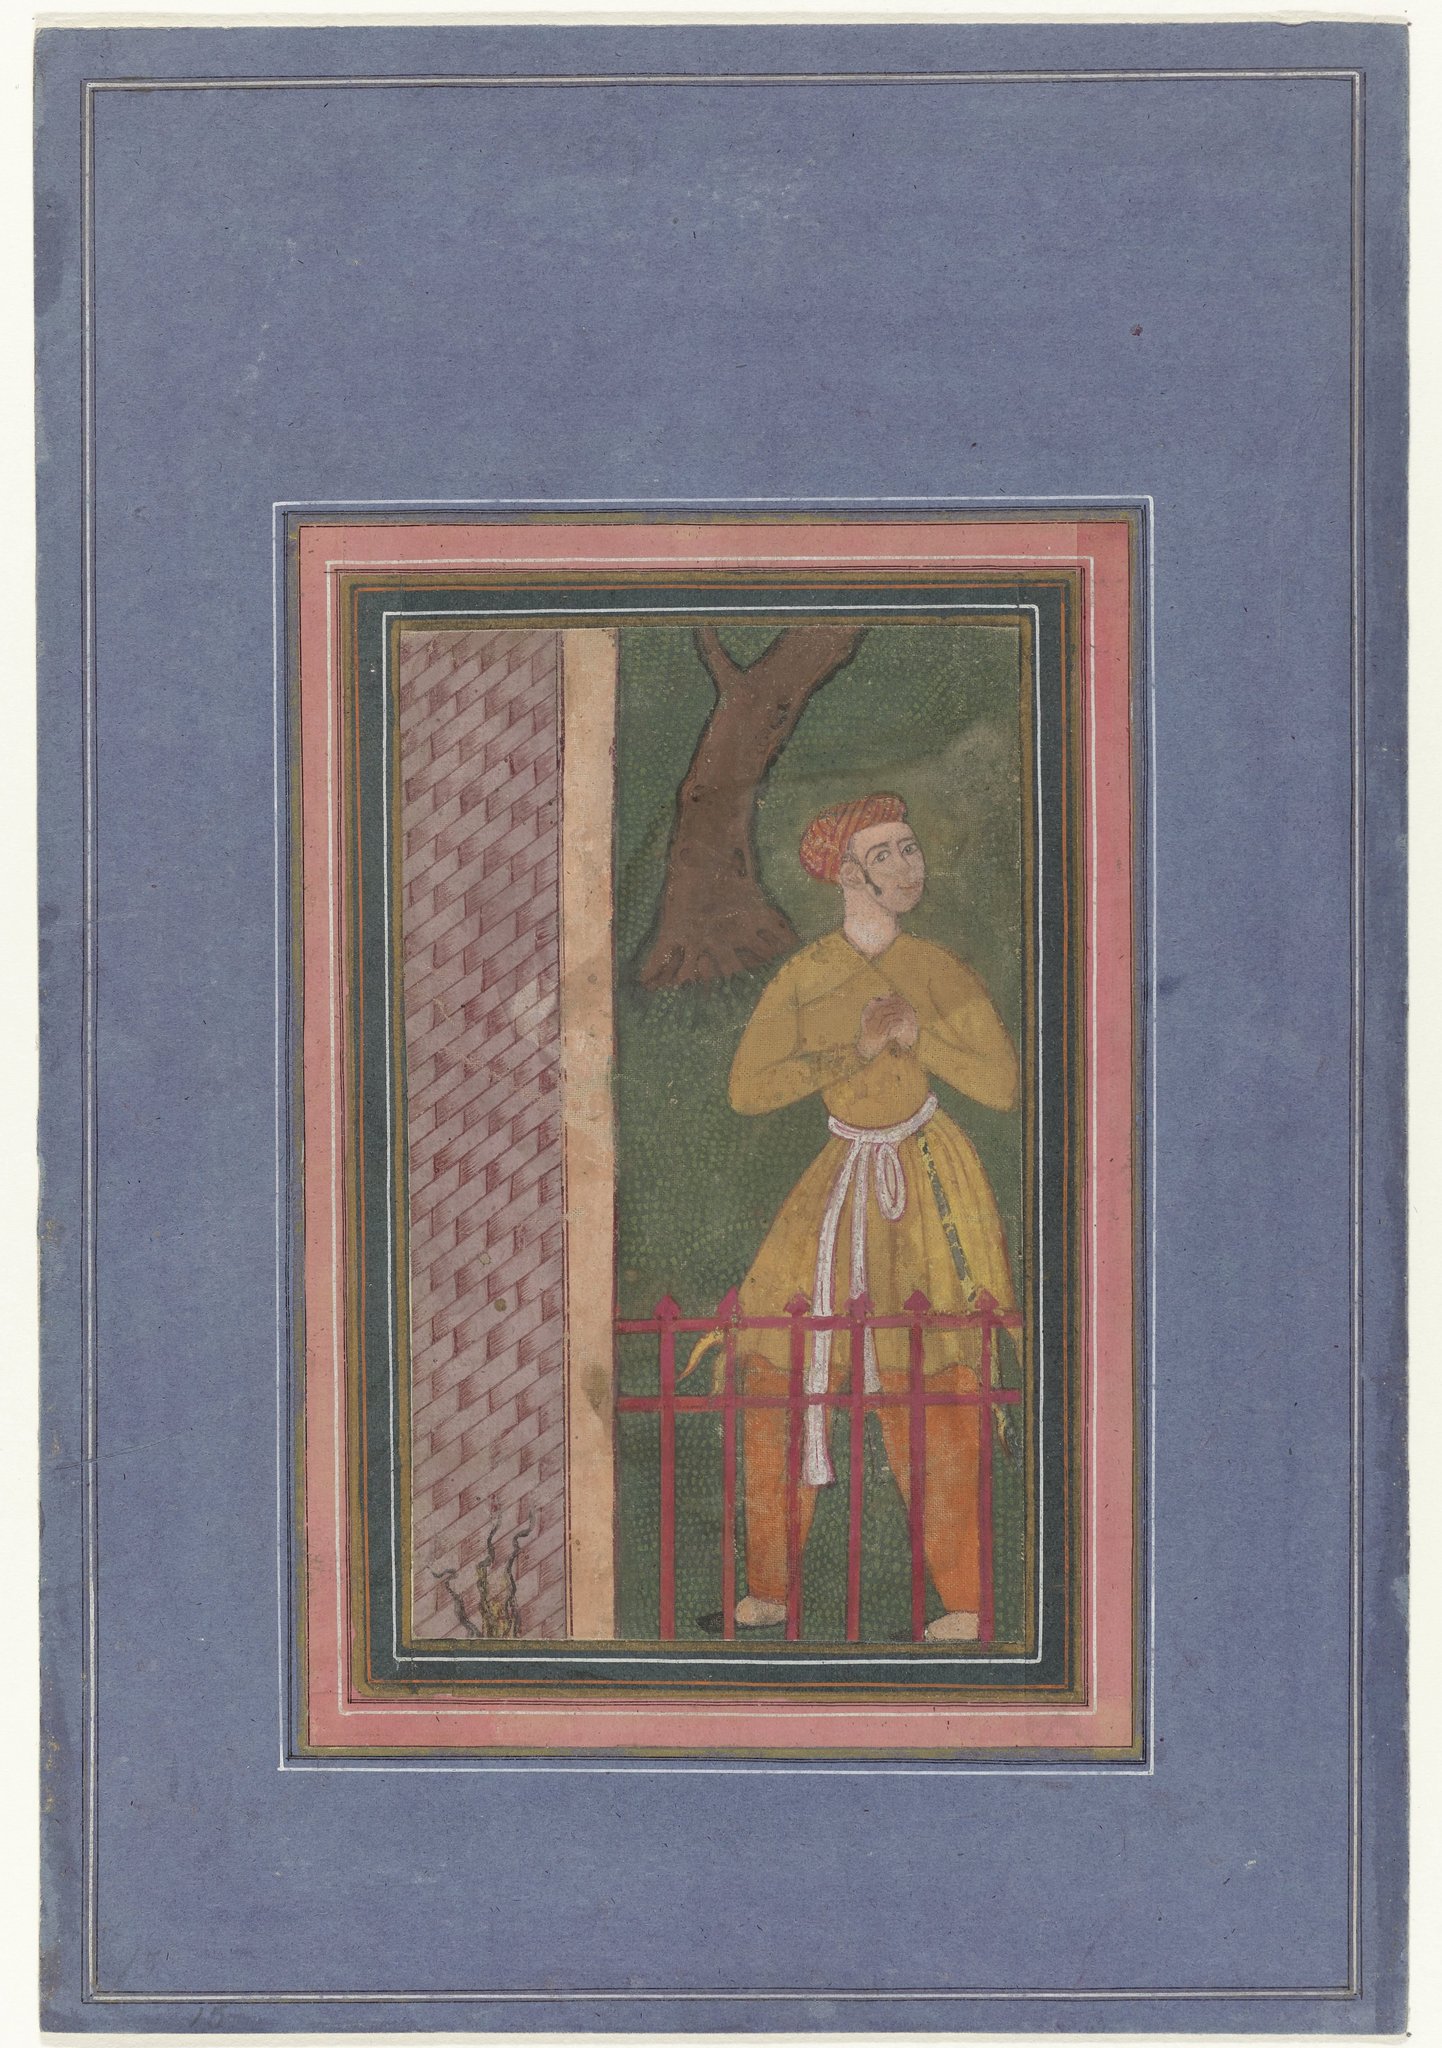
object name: indian miniature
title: Staande man achter een hek; fragment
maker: Anonymous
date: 1565-1575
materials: cotton, paint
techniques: brush